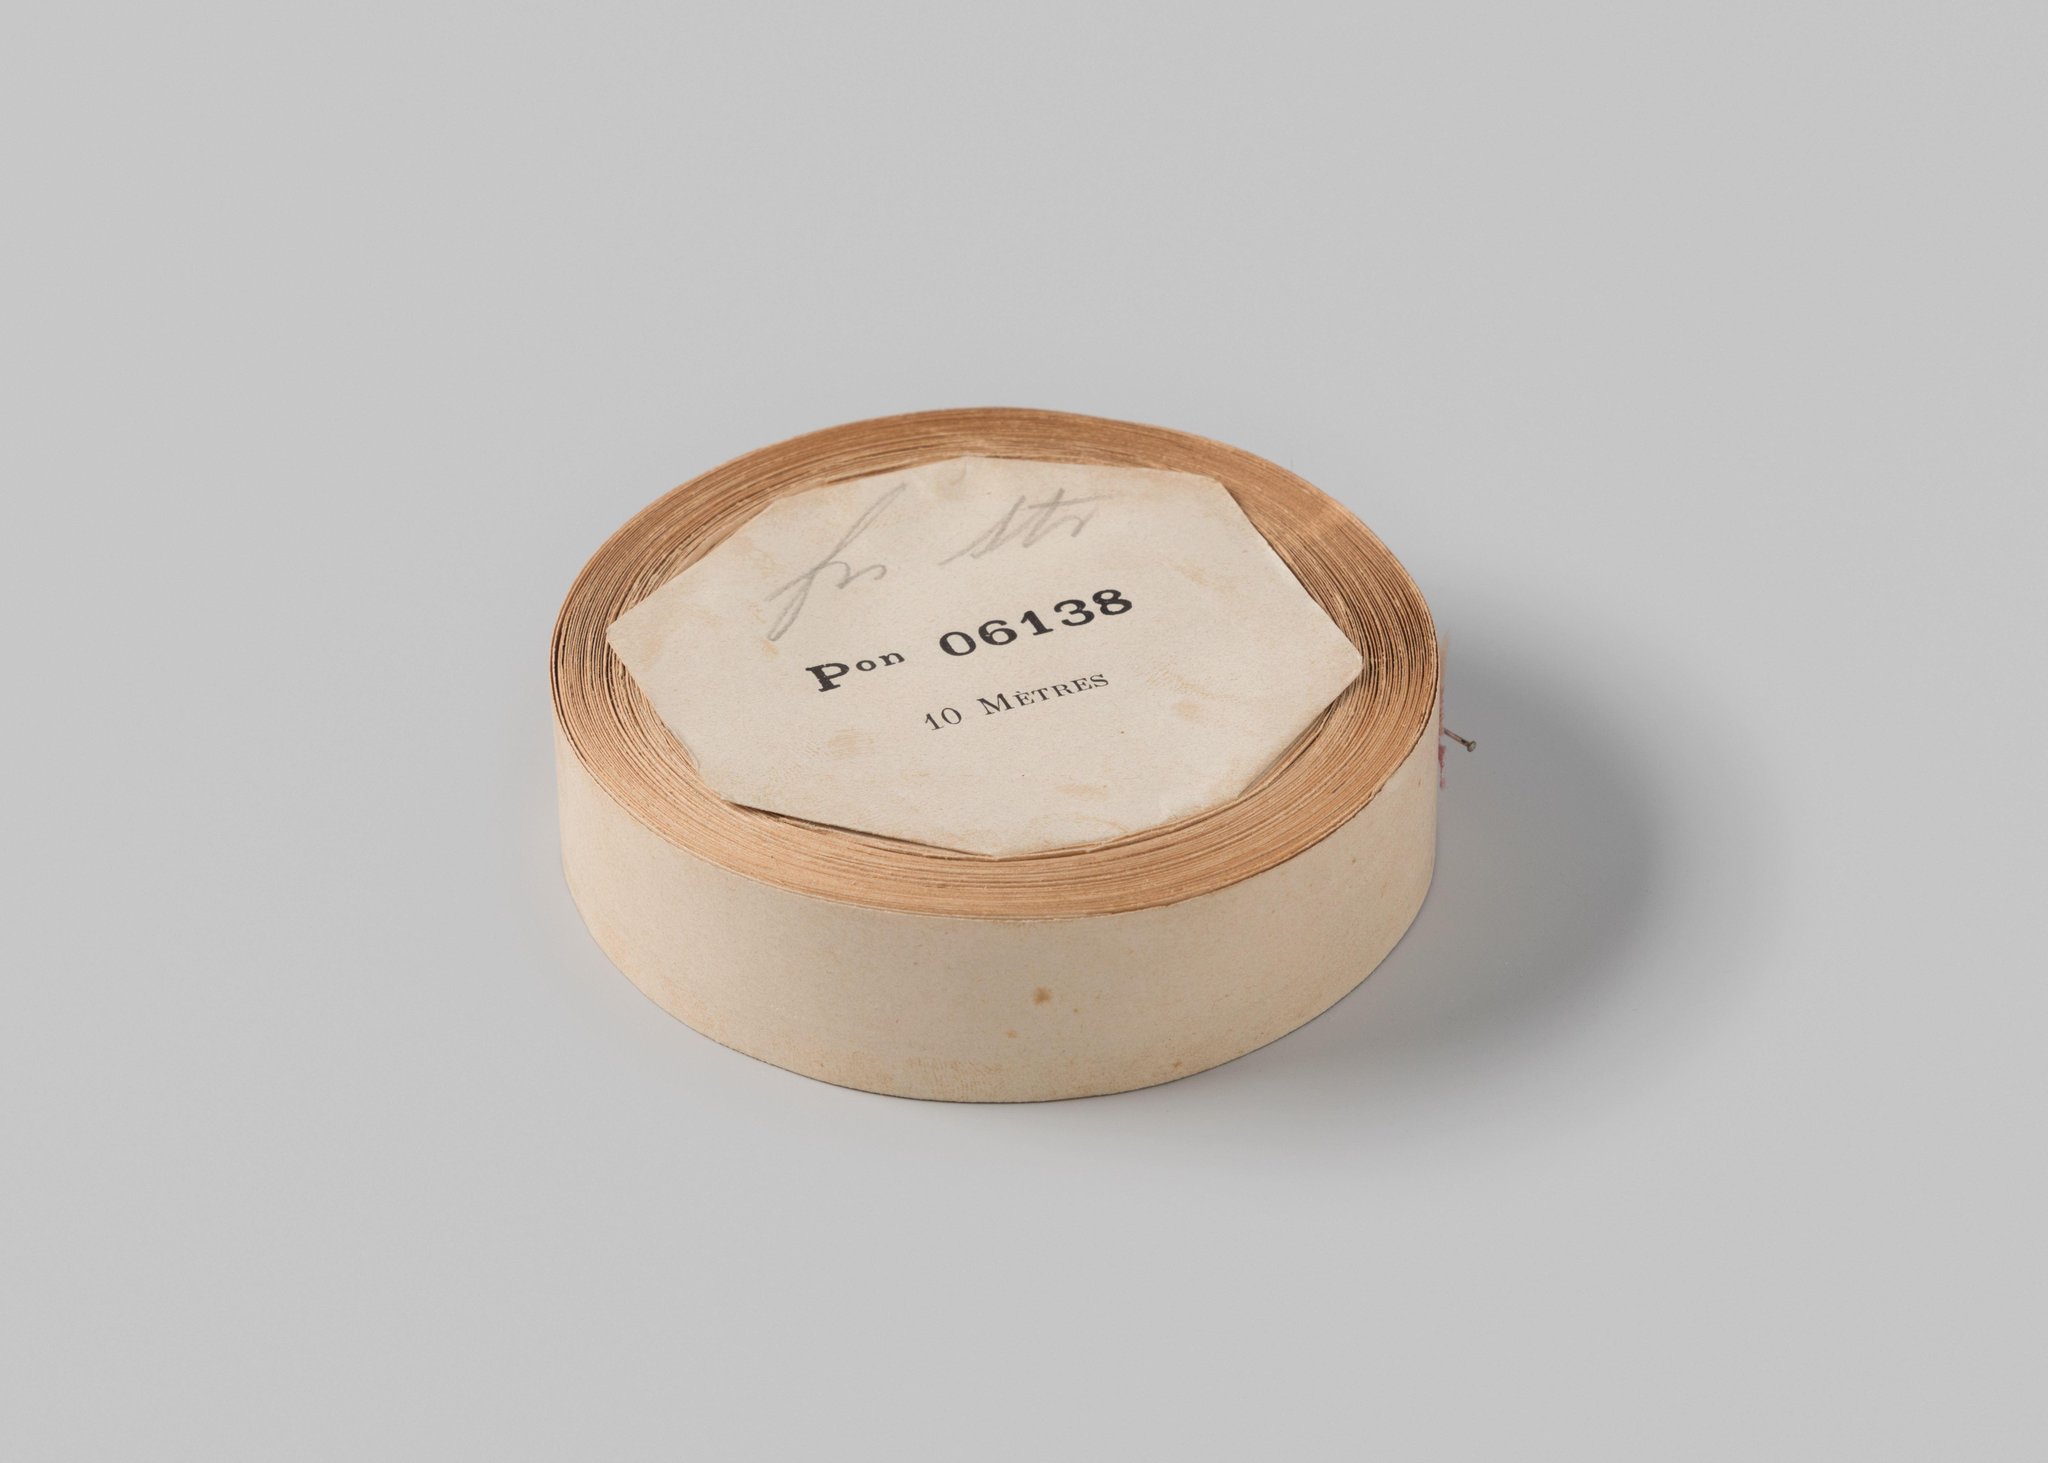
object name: braid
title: Rol met lila satijnlint met één gerafelde zijde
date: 1935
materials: cardboard, paper, textile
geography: nijmegen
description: Rol met lila satijnlint met één gerafelde zijde.